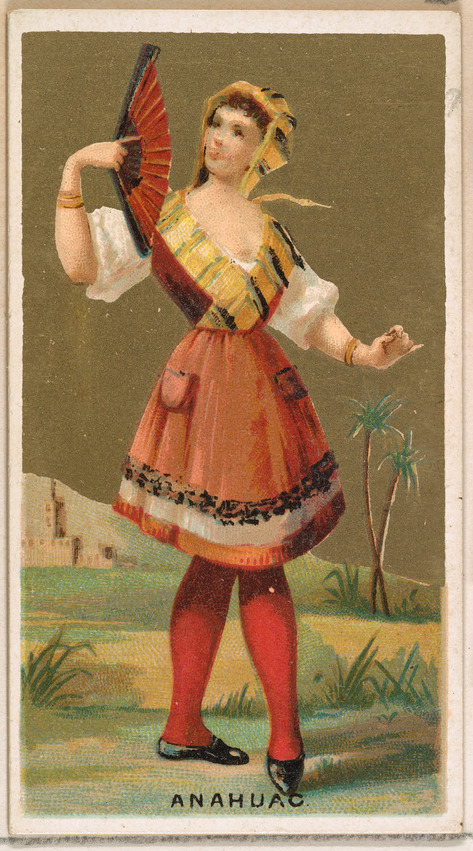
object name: print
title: Anahuac, from the Dancing Girls of the World series (N185) issued by Wm. S. Kimball & Co.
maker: william s. kimball & company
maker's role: publisher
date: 1889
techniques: color lithograph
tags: women,dancers